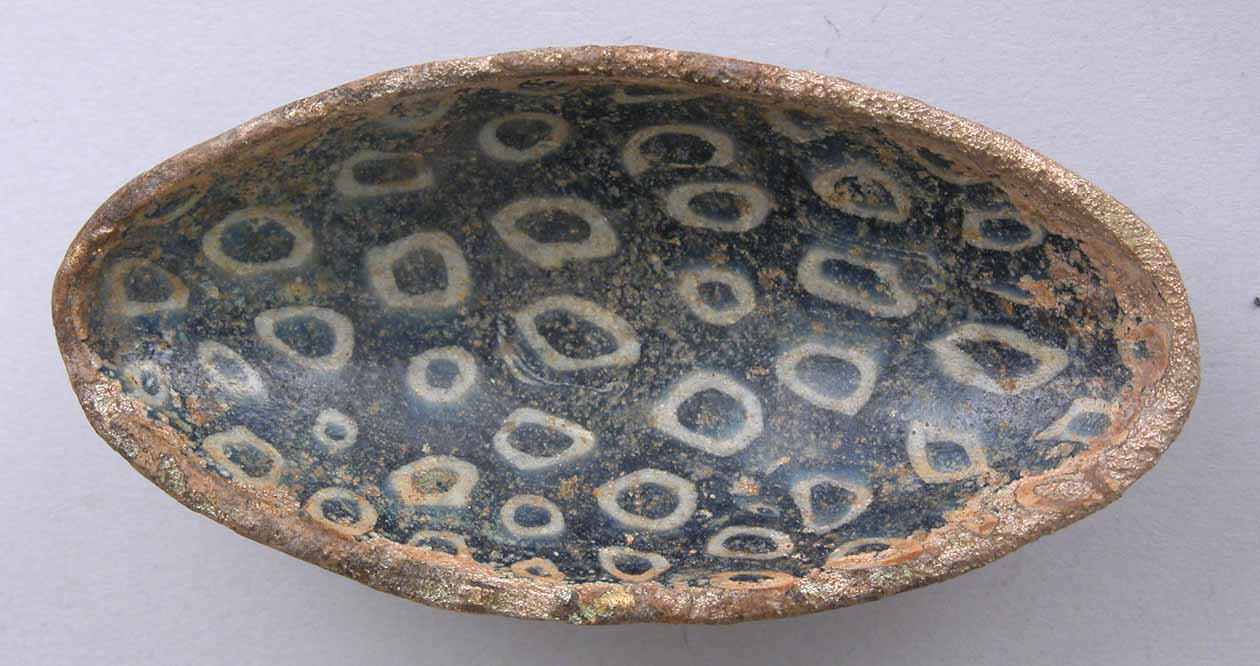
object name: bowl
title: Small Millefiori Bowl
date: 801-900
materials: glass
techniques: polish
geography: iraq